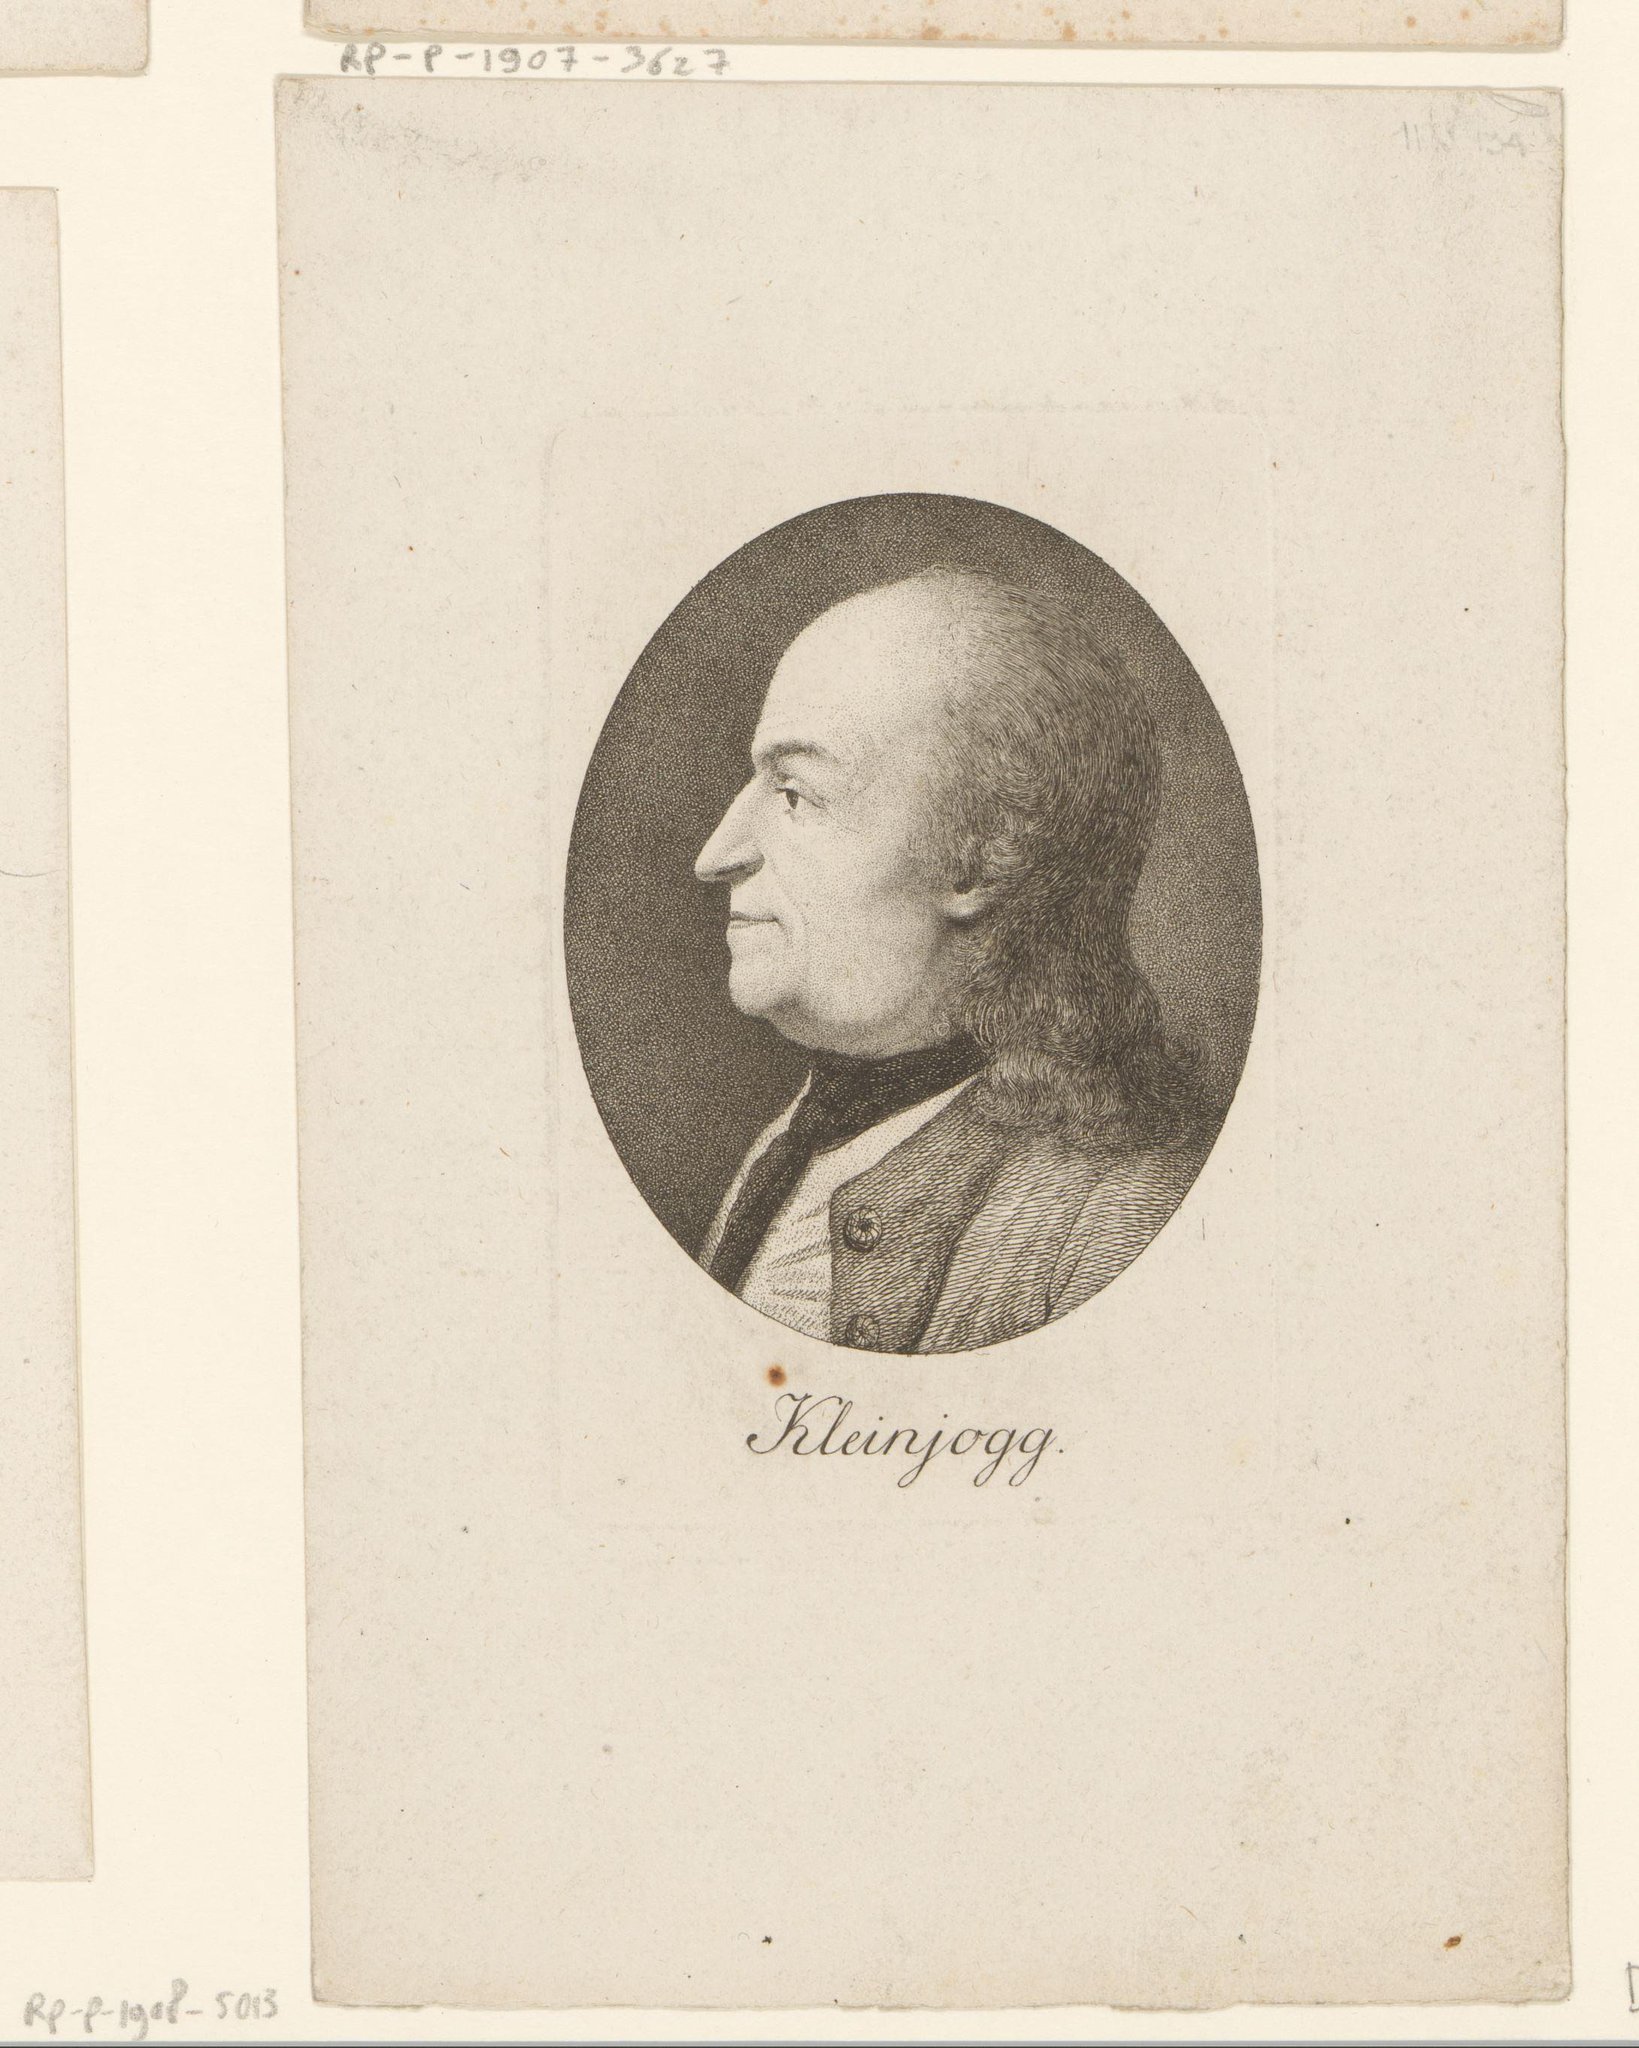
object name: print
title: Portret van Kleinjogg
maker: heinrich pfenninger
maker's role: print maker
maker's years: 1749-1815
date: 1759-1815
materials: paper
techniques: etching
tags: switzerland, historical persons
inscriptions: collector's mark: Lugt 2228